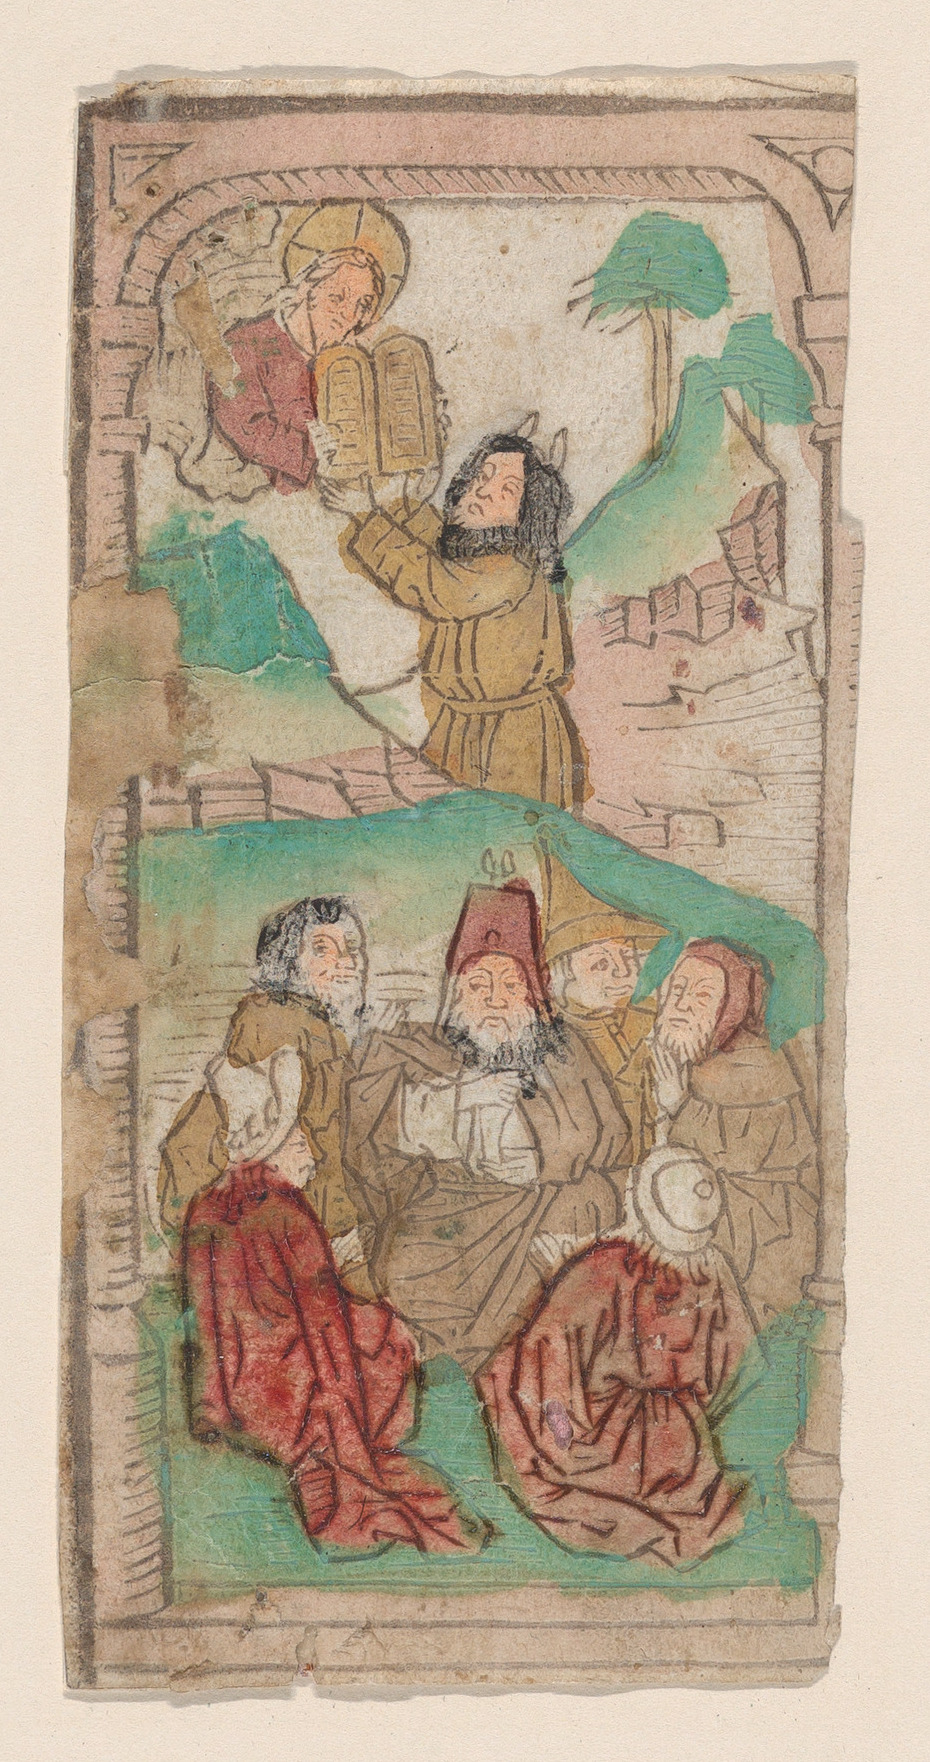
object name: print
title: Moses Receiving the Law, illustration from a "Biblia Pauperum" blockbook, fourth edition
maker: anonymous, netherlandish, 15th century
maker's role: artist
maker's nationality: netherlandish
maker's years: 1400-1500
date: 1465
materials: ink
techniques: hand coloring, printing, woodcut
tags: men,moses